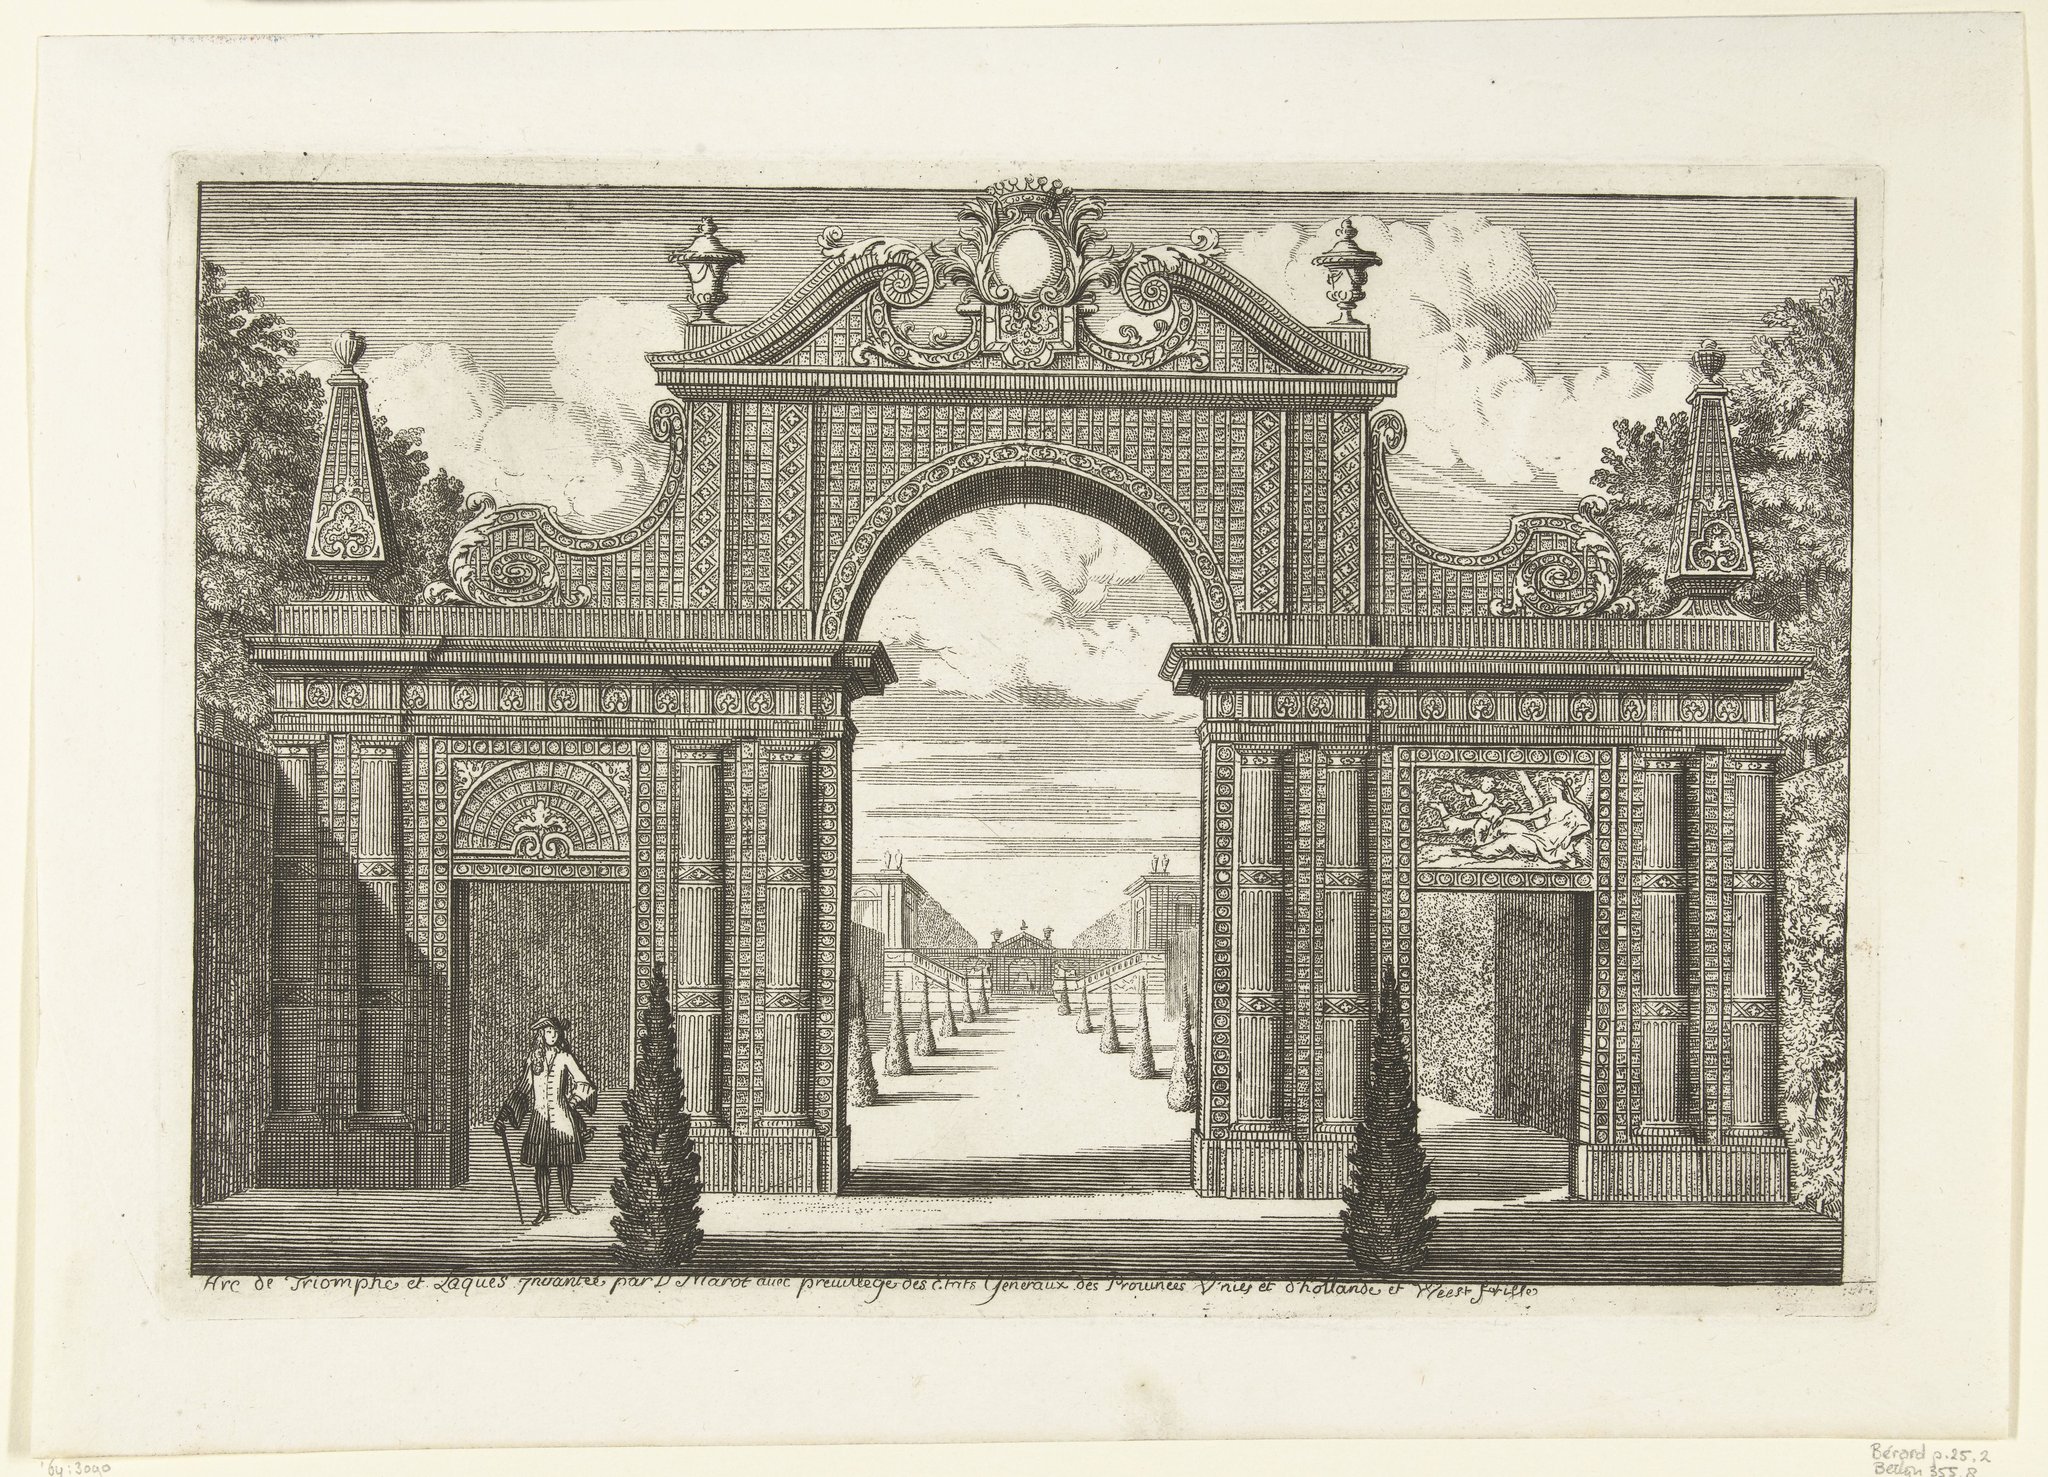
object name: ornament print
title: Nouveaux Liure de Bersseaux et Trilliages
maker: daniël marot (i)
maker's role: draughtsman, print maker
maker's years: 1661-1752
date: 1702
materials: paper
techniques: etching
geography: netherlands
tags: trellis, triumphal arch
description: Met een variant voor het paneel boven de kleinere doorgangen. Uit serie van 6 bladen.